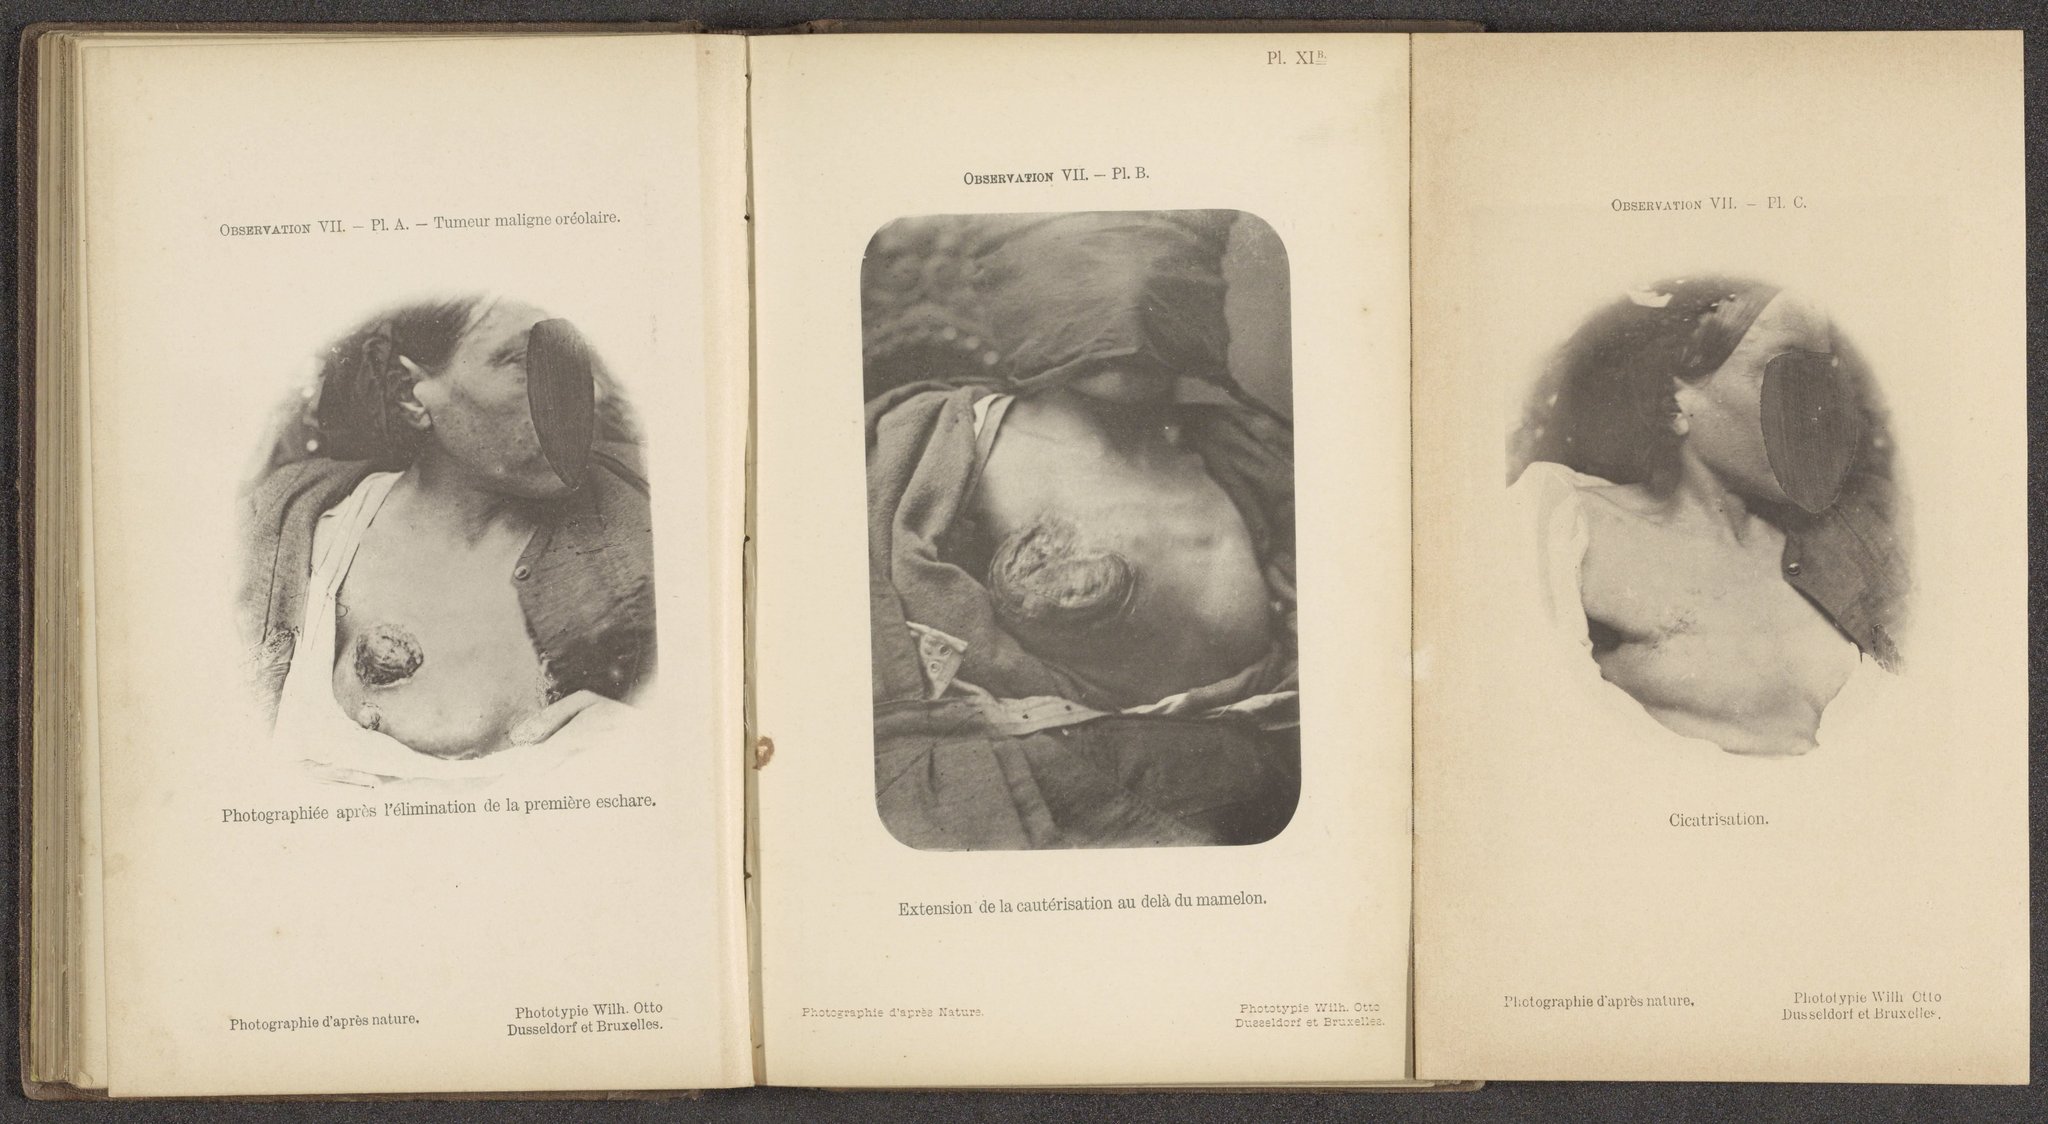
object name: page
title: Vrouw met een wond op haar borst door een kwaadaardige tumor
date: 1874-1884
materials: paper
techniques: photograph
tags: tumours - aa - female human figure, infections and wounds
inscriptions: inscription: ‘Pl. XIB. / Observation VII. - Pl. B. / Extension de la cautérisation au delà du mamelon.’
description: Onderdelen 13 en 14 vormen een leporello.